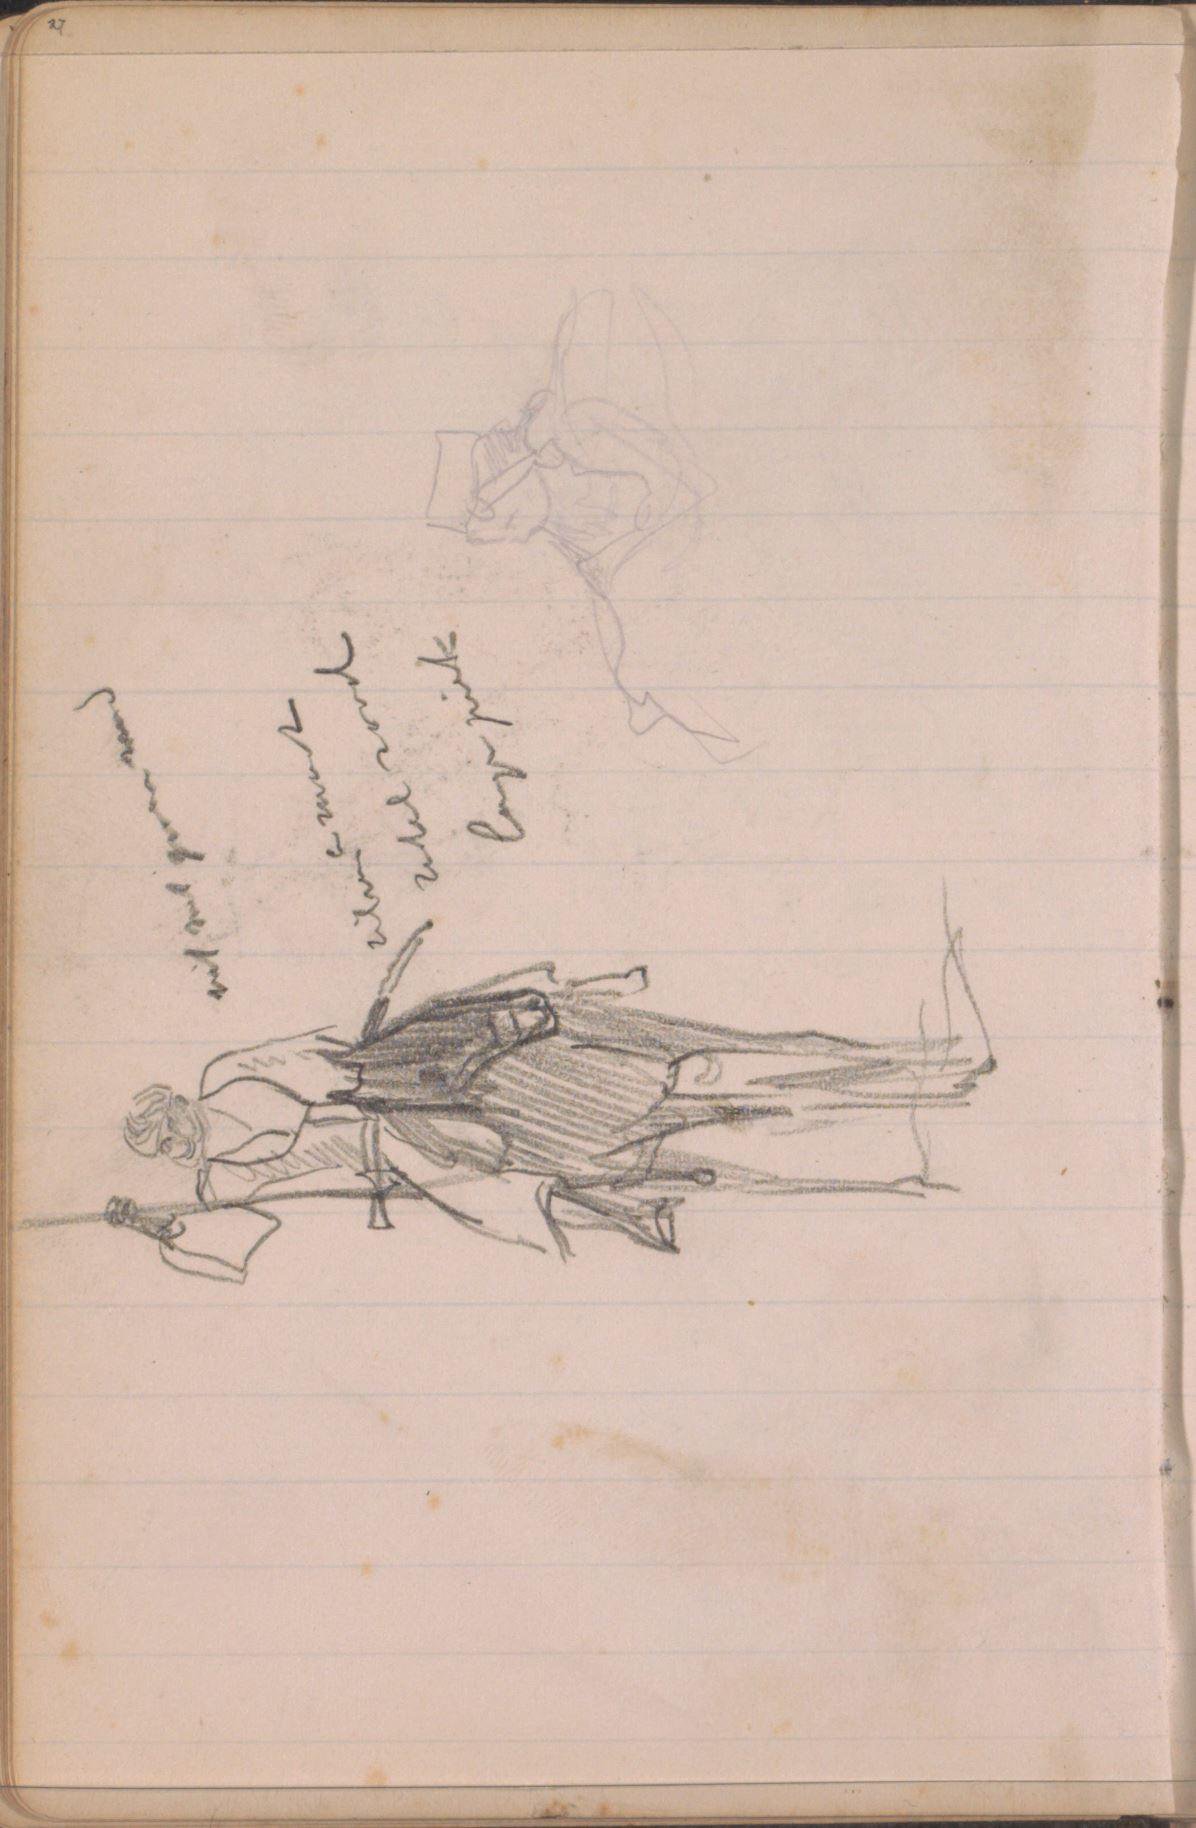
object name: sketchbook leaf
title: Ruiter met zwaard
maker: marius bauer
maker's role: draughtsman, print maker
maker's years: 1867-1932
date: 1897-1898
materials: pencil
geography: india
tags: riding a horse, ass, or mule; rider, horseman, head (human), hacking and thrusting weapons: sword, asiatic races and peoples: indians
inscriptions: kleurnotitie, handgeschreven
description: Tevens een studie van een kop met hoofddeksel. Pagina 27 uit een schetsboek met 84 bladen.